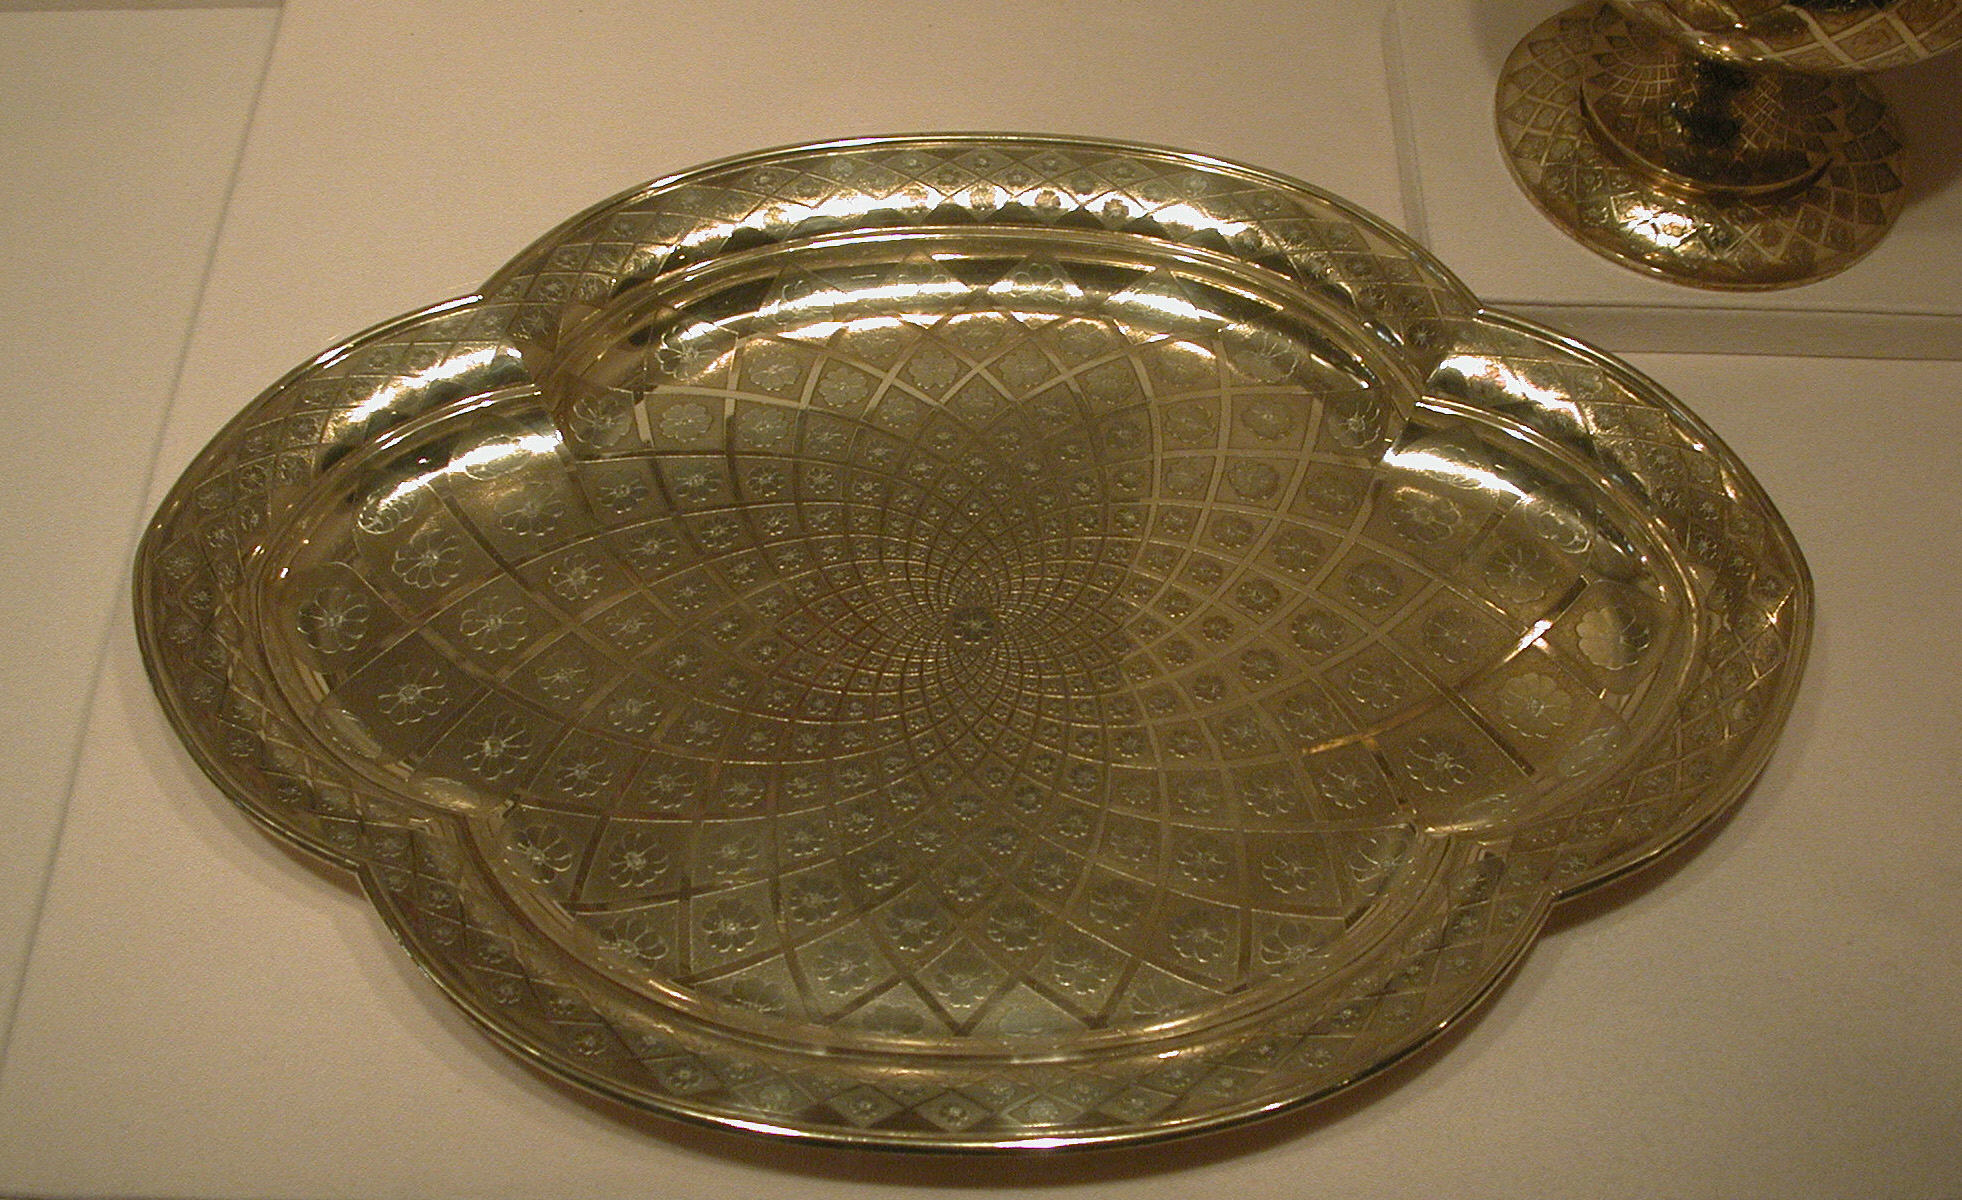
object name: basin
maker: françois-desiré froment-meurice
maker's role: maker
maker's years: 1802-1855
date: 1850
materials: silver gilt